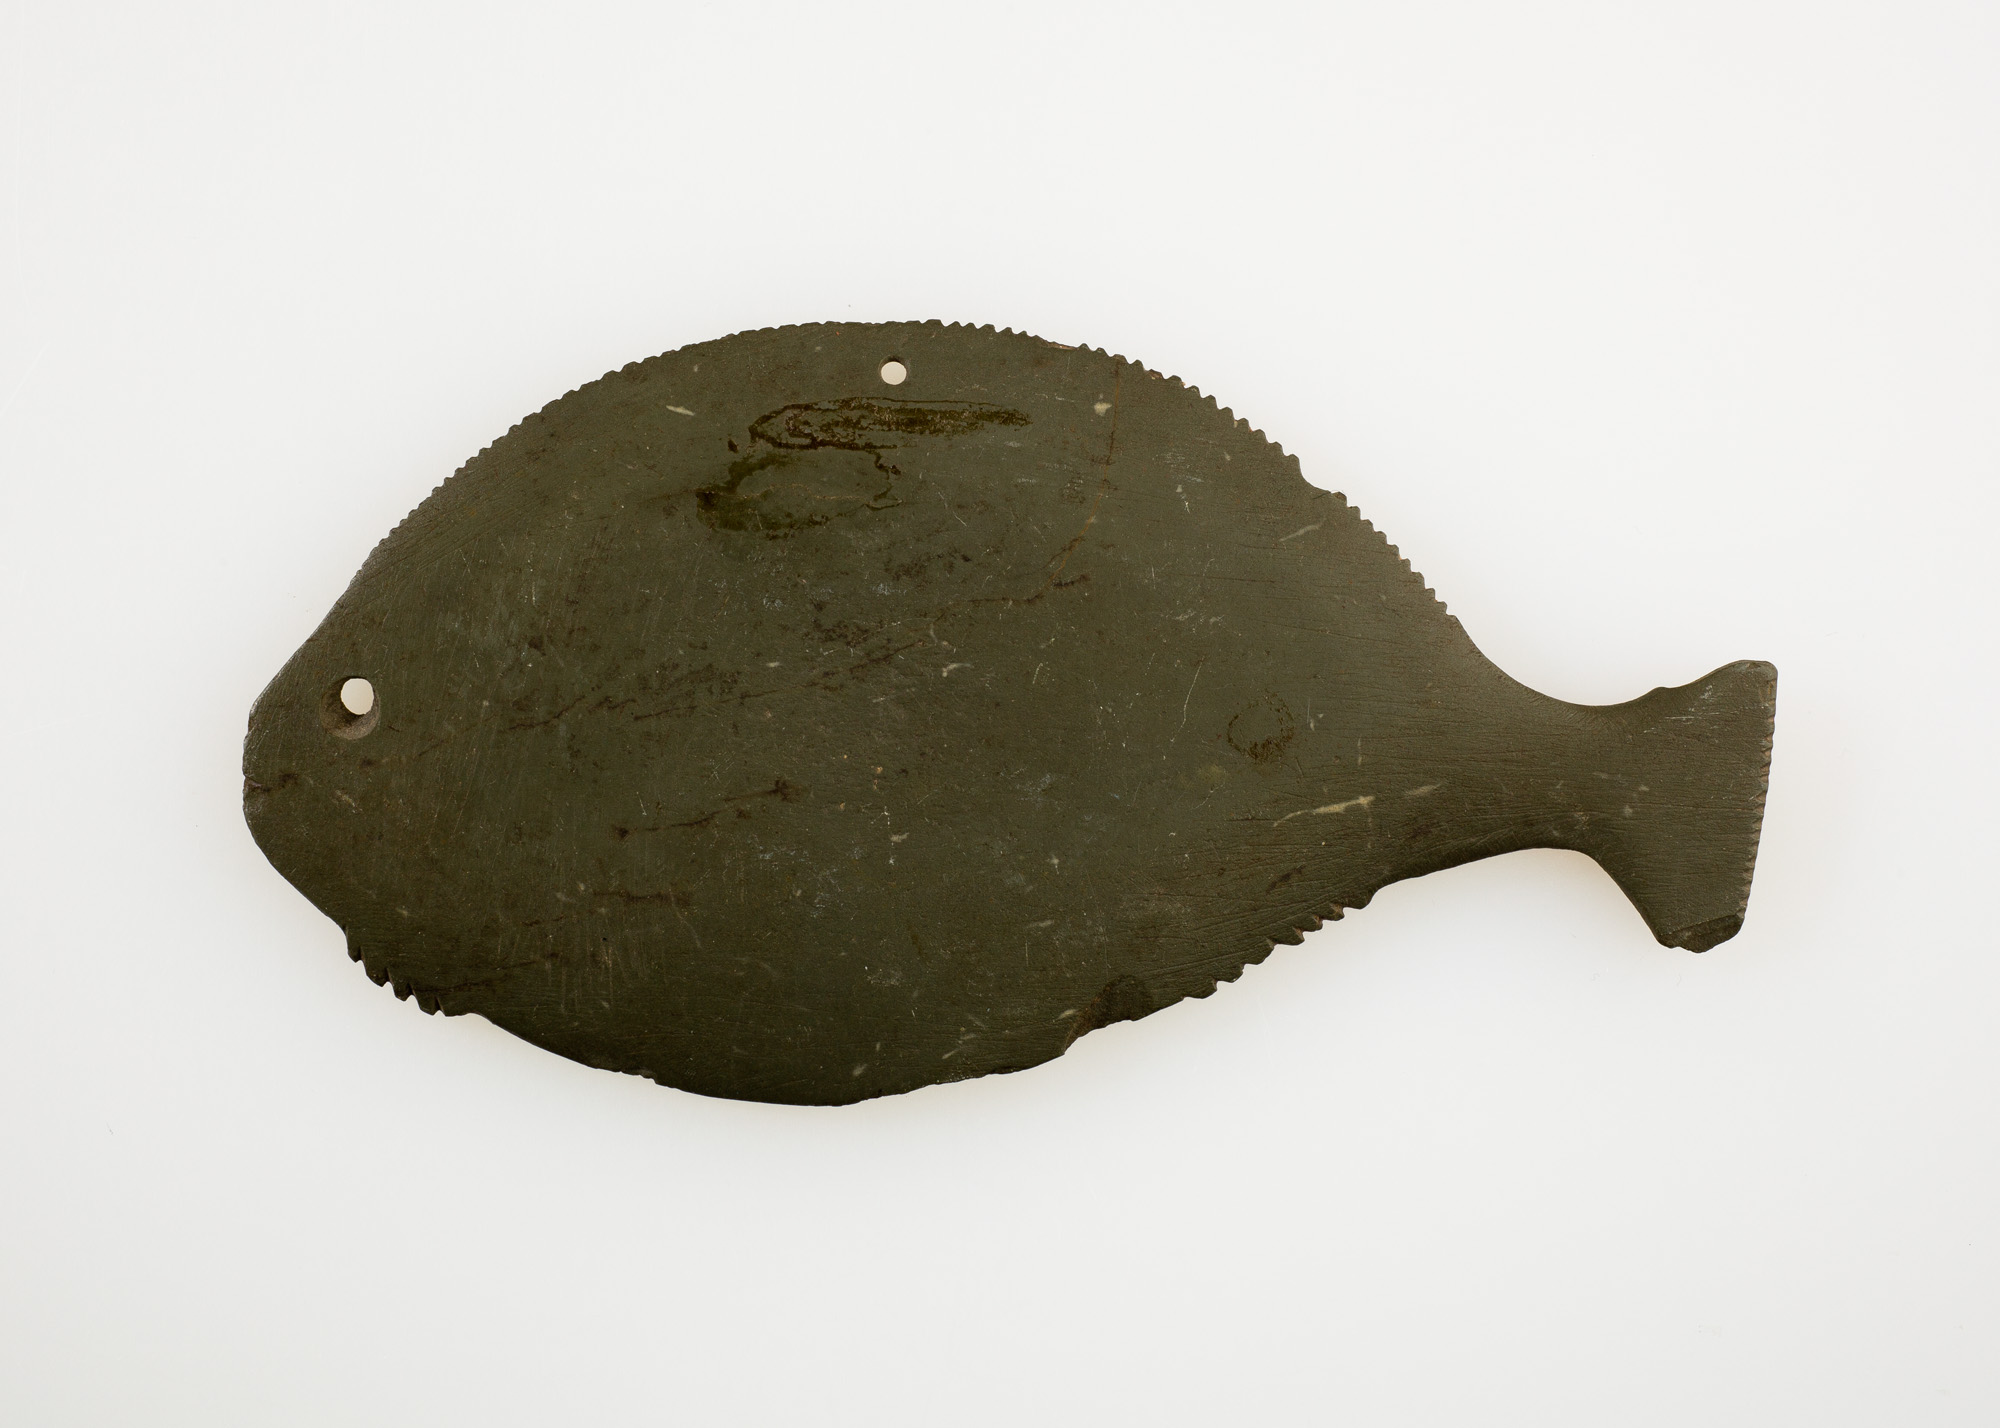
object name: palette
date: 3850-2960 BCE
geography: egypt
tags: fish